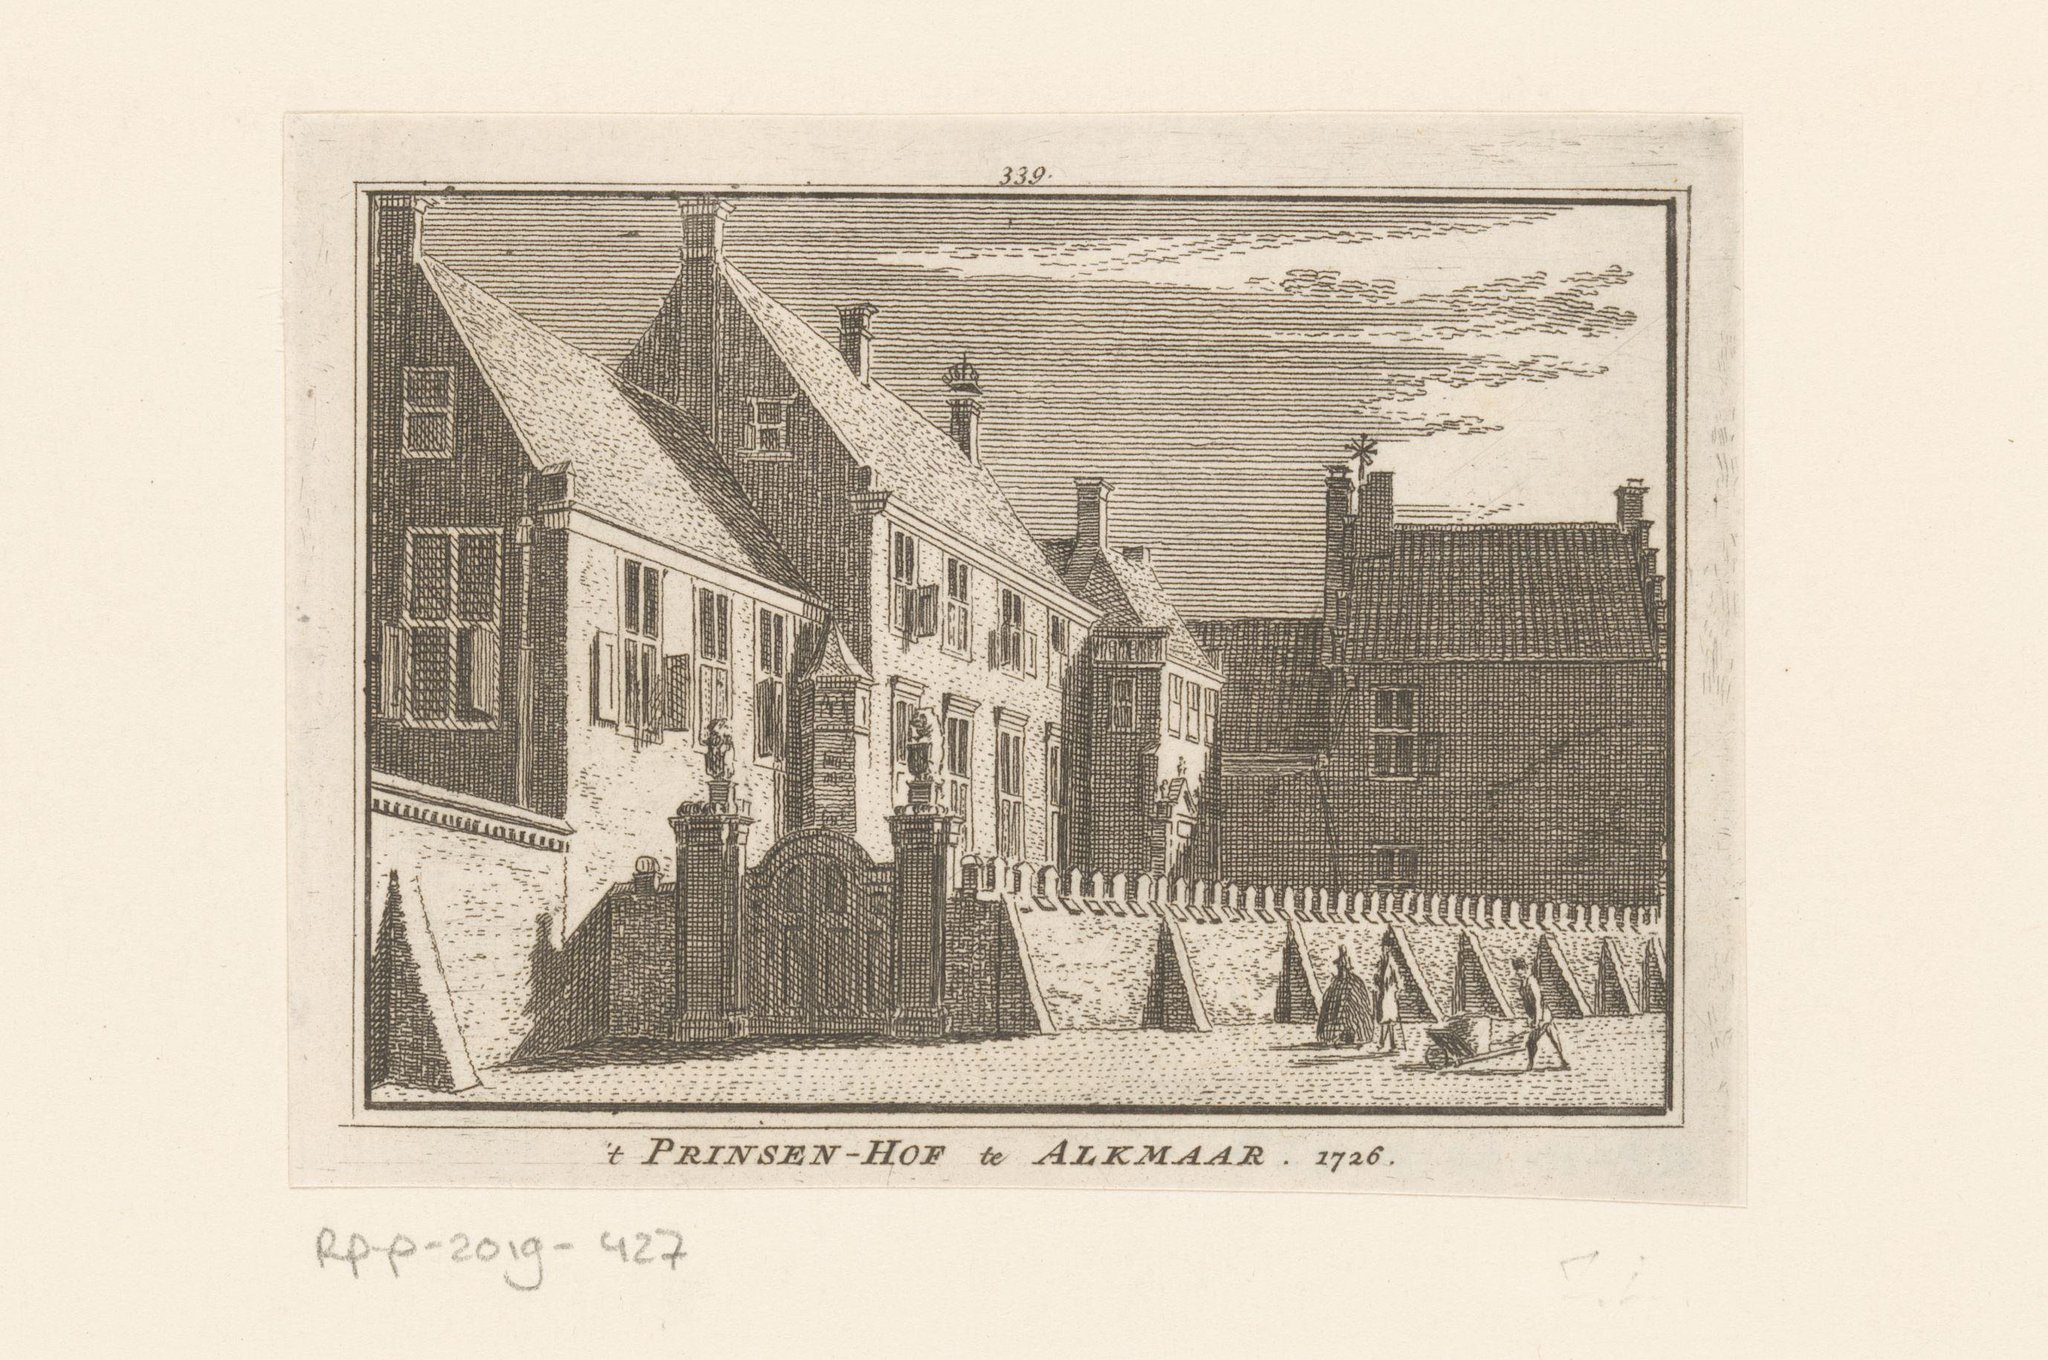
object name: print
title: 't Prinsen-Hof te Alkmaar. 1726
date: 1746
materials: paper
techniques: etching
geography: amsterdam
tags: civic architecture; edifices; dwellings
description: Prent verschenen in: Het verheerlykt Nederland, of, Kabinet van hedendaagsche gezigten van steden, dorpen (...). Amsterdam: Isaak Tirion, 1746. De prent is het bovenste deel van een plaat met twee gezichten op Alkmaar.